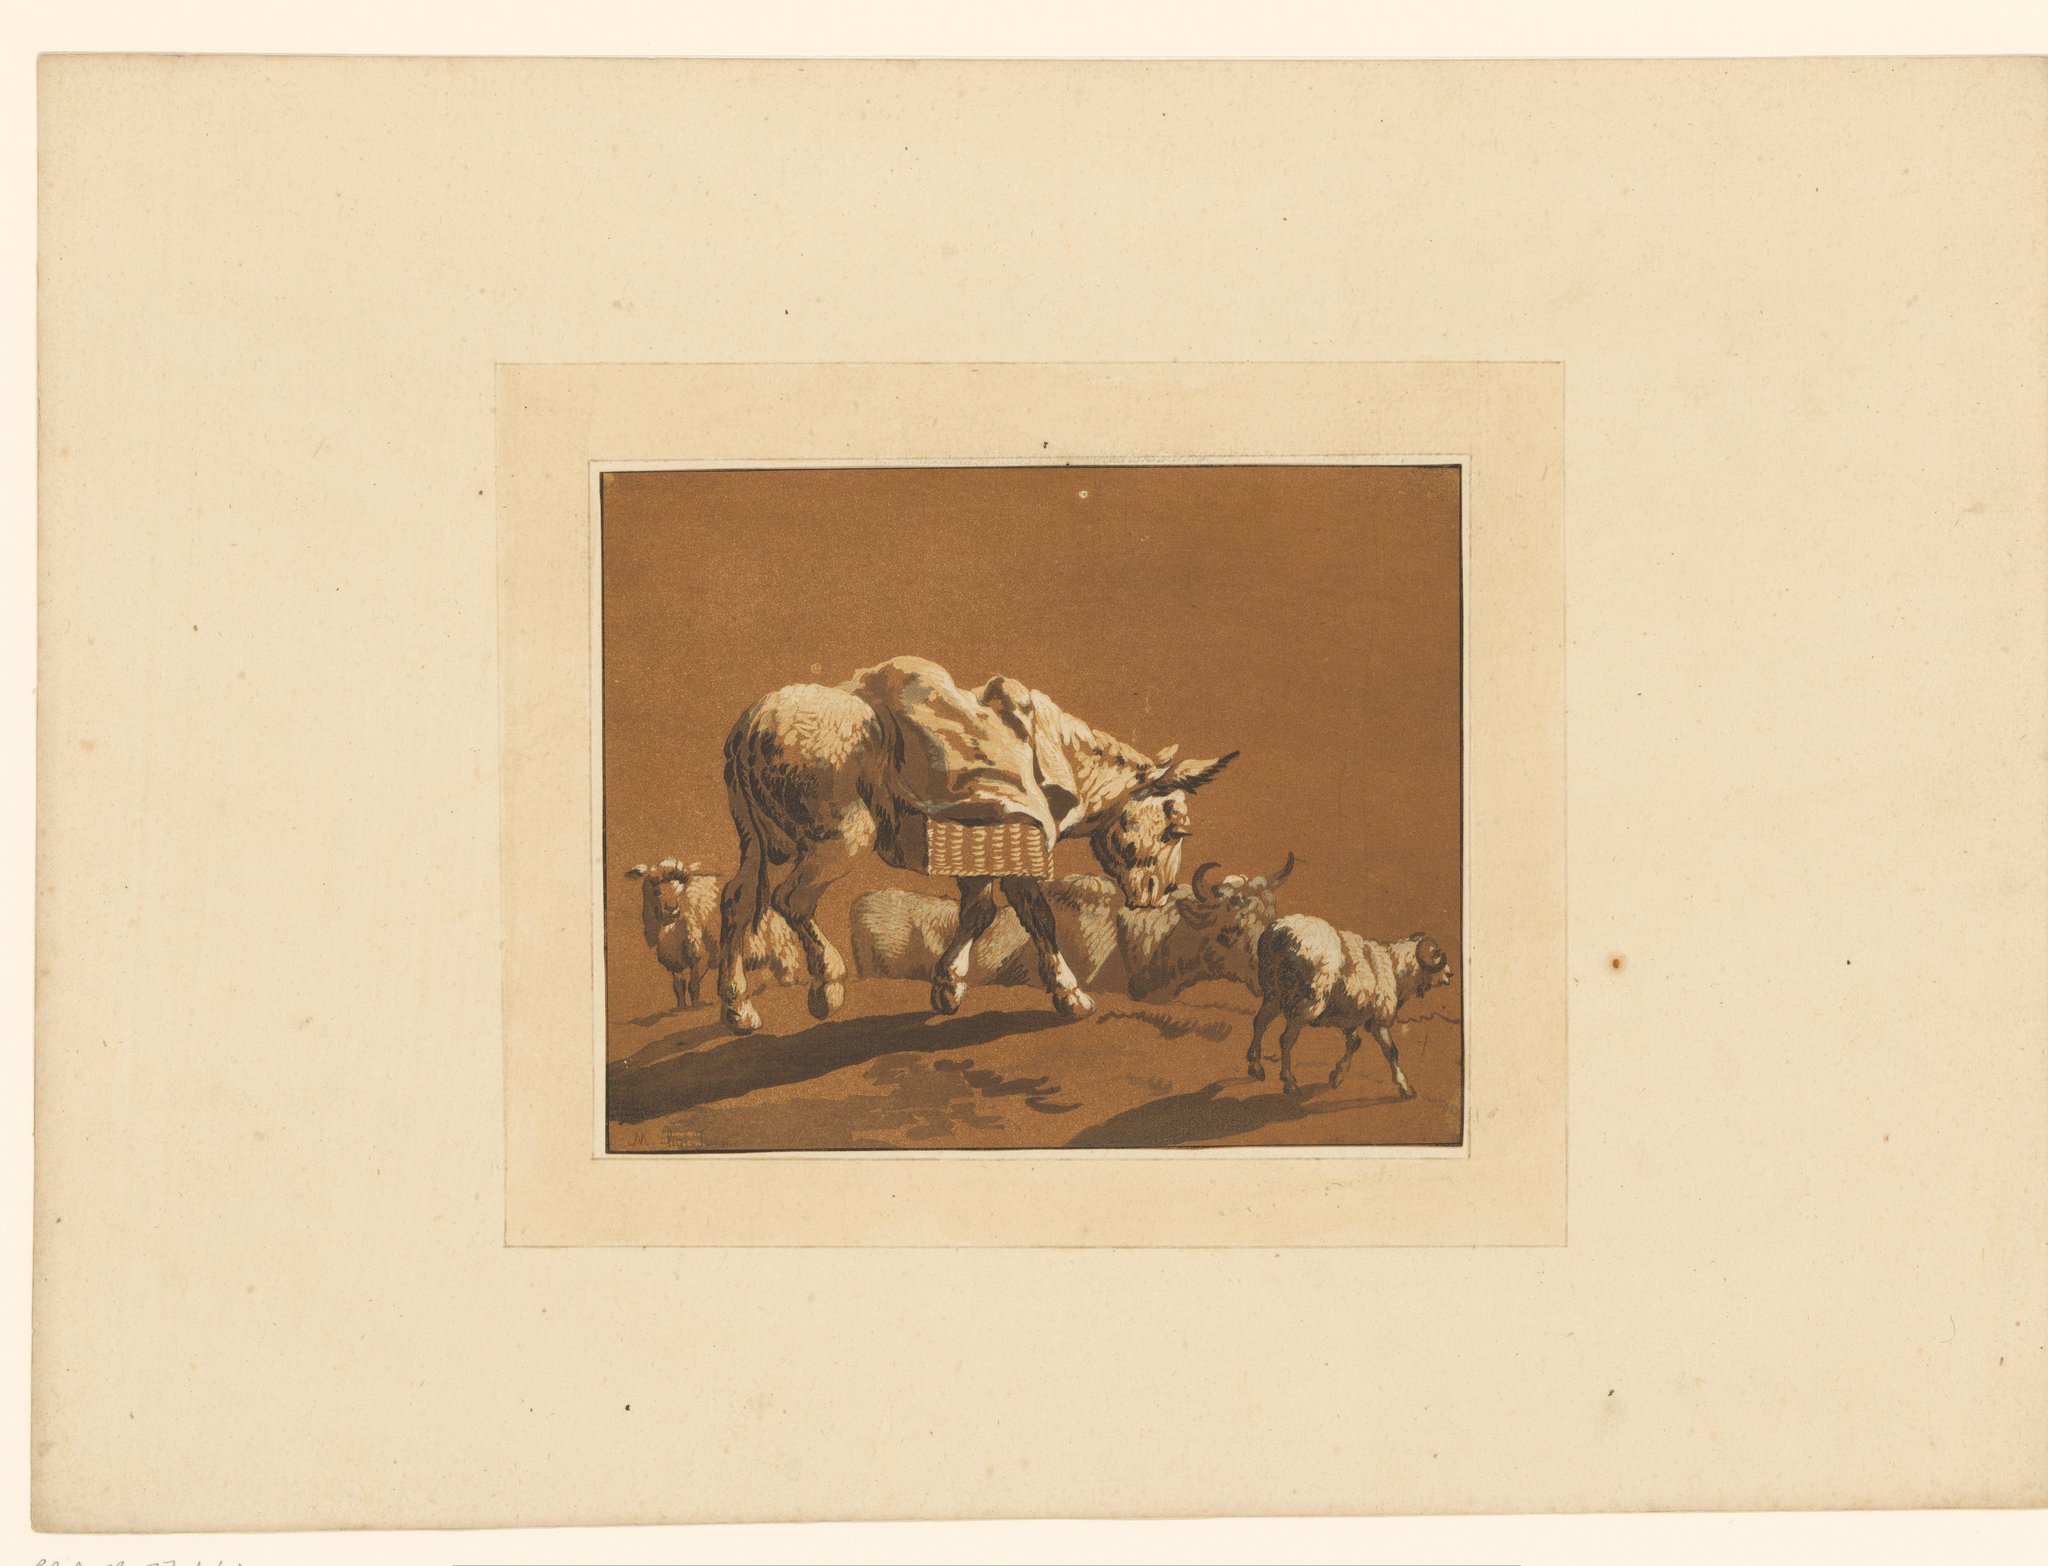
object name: print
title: Landschap met vee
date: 1783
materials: paper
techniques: aquatint, etching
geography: nuremberg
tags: cattle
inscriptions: collector's mark: Lugt 2228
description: Nummer 16 uit het prentenalbum 'Dessins des meilleurs Peintres d'Italie, d'Allemagne, et des Pays-Bas, Tirés de divers célebres Cabinets. Gravés d'apres les Originaux de même grandeur par Jean Théophile Prestel'. Neurenberg: J.G. Prestel, 1783.